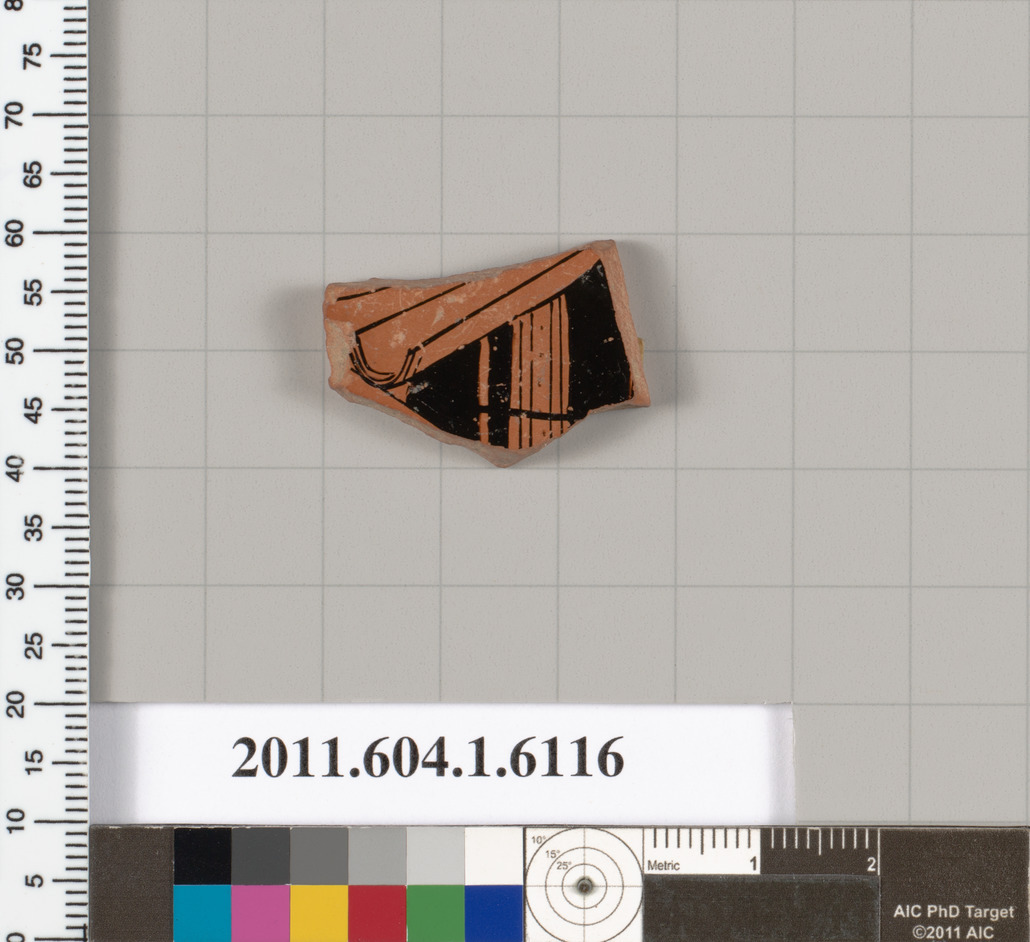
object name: kylix fragment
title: Terracotta fragment of a kylix (drinking cup)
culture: greek, attic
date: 510-490 BCE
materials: terracotta